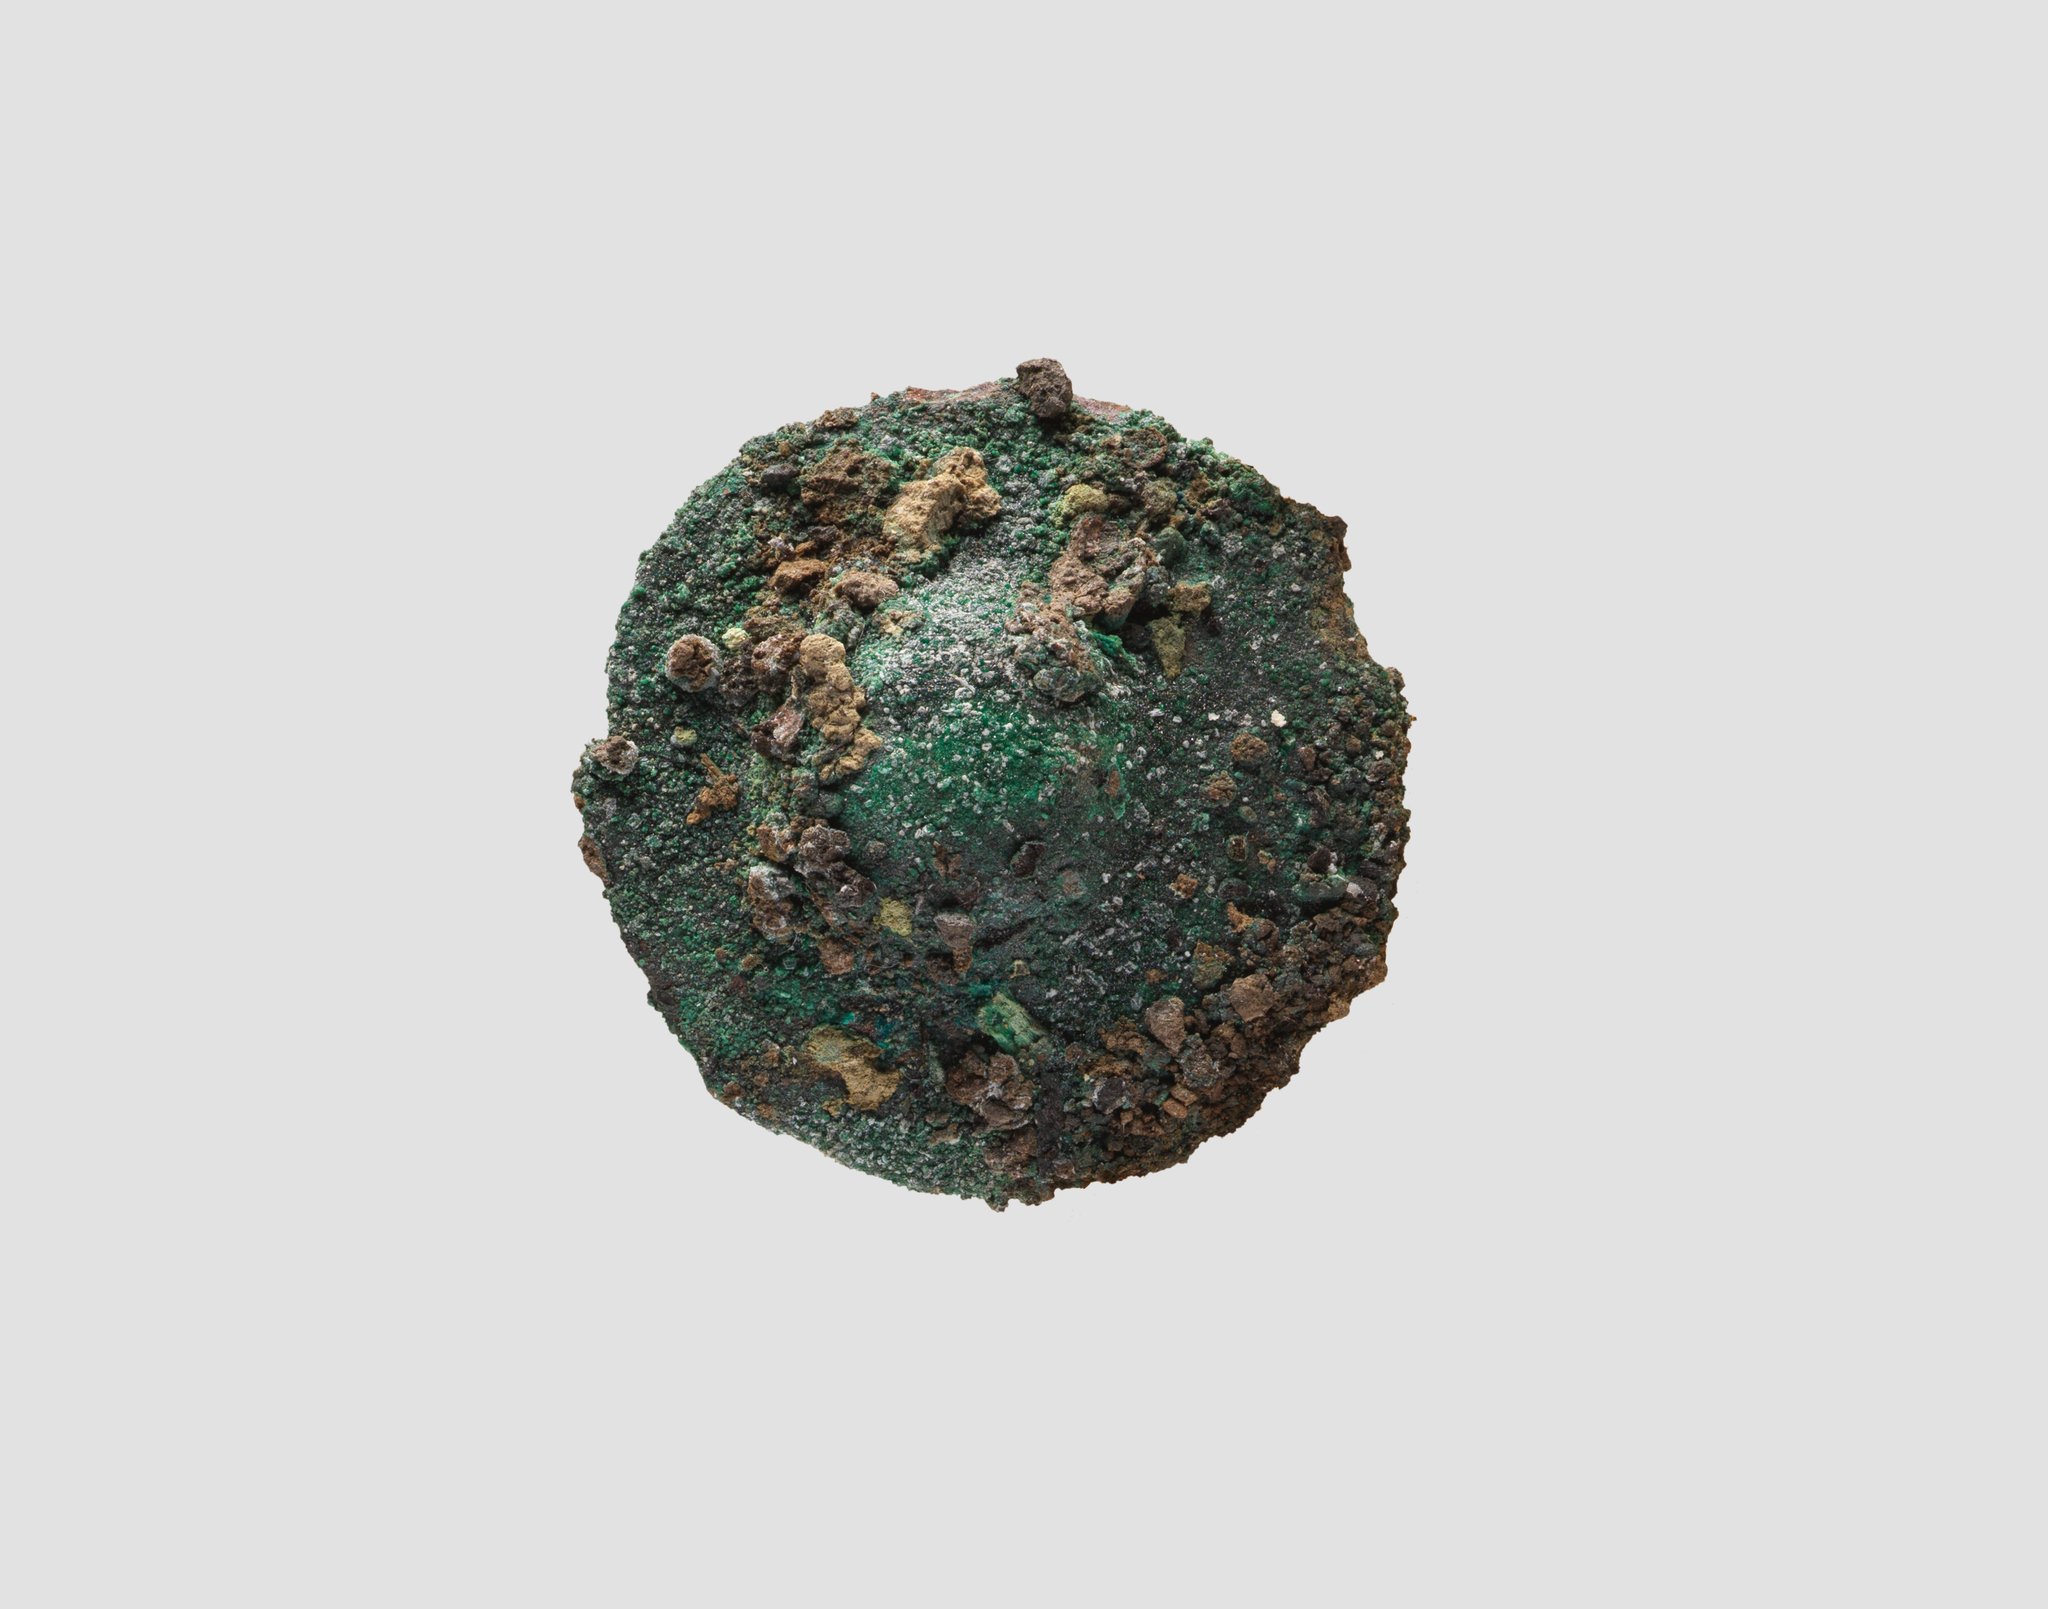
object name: stud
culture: iranian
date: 900-801 BCE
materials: bronze, copper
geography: iran